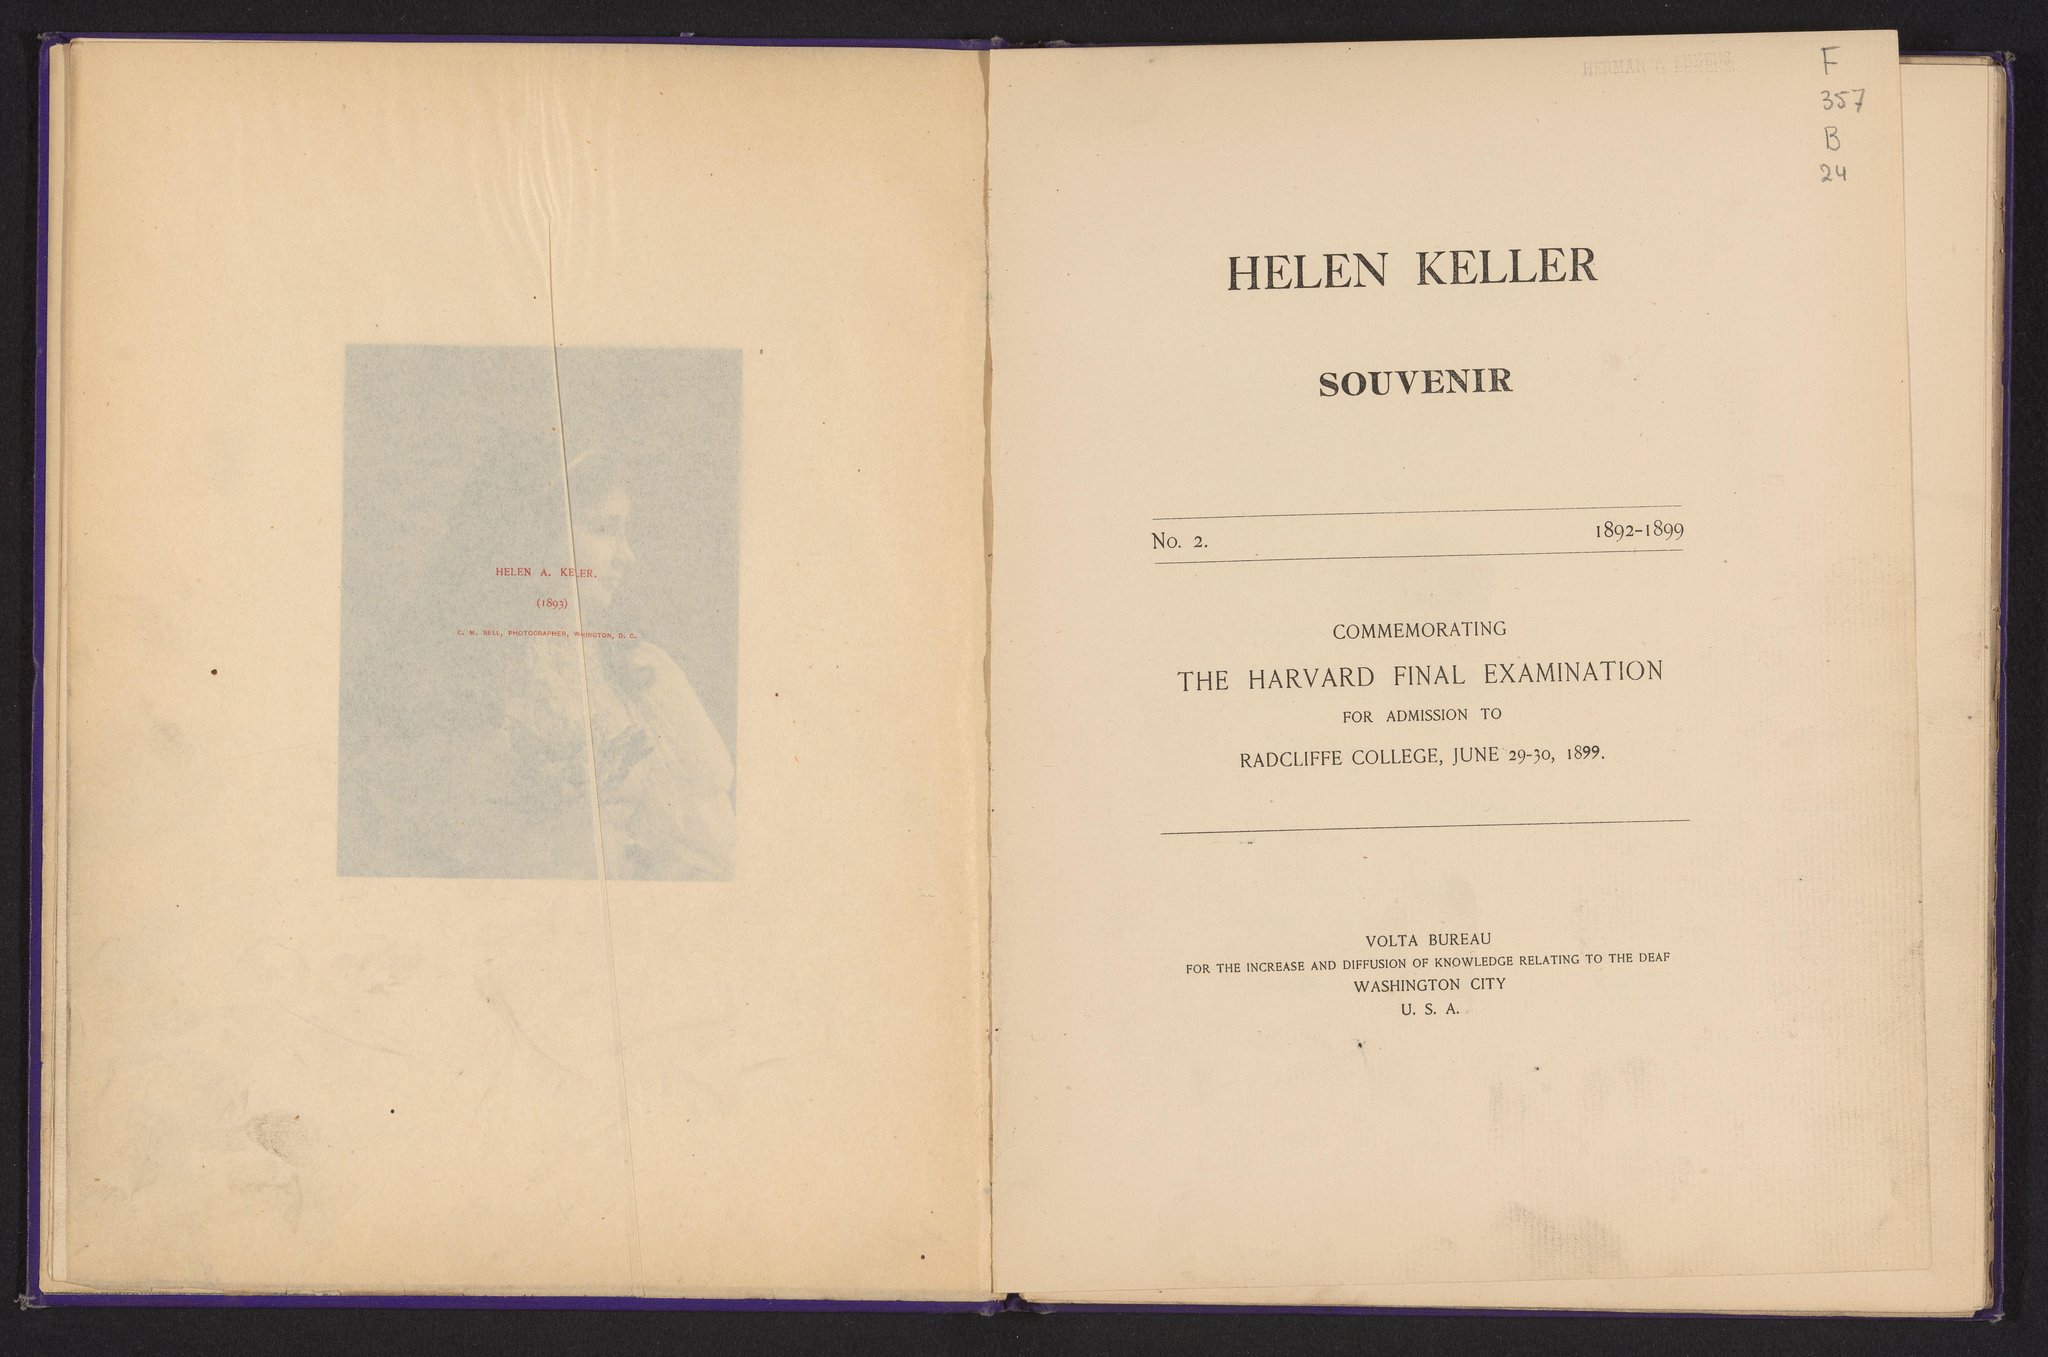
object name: book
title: Helen Keller souvenir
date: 1899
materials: cardboard, linen, paper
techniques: photograph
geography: washington d.c.